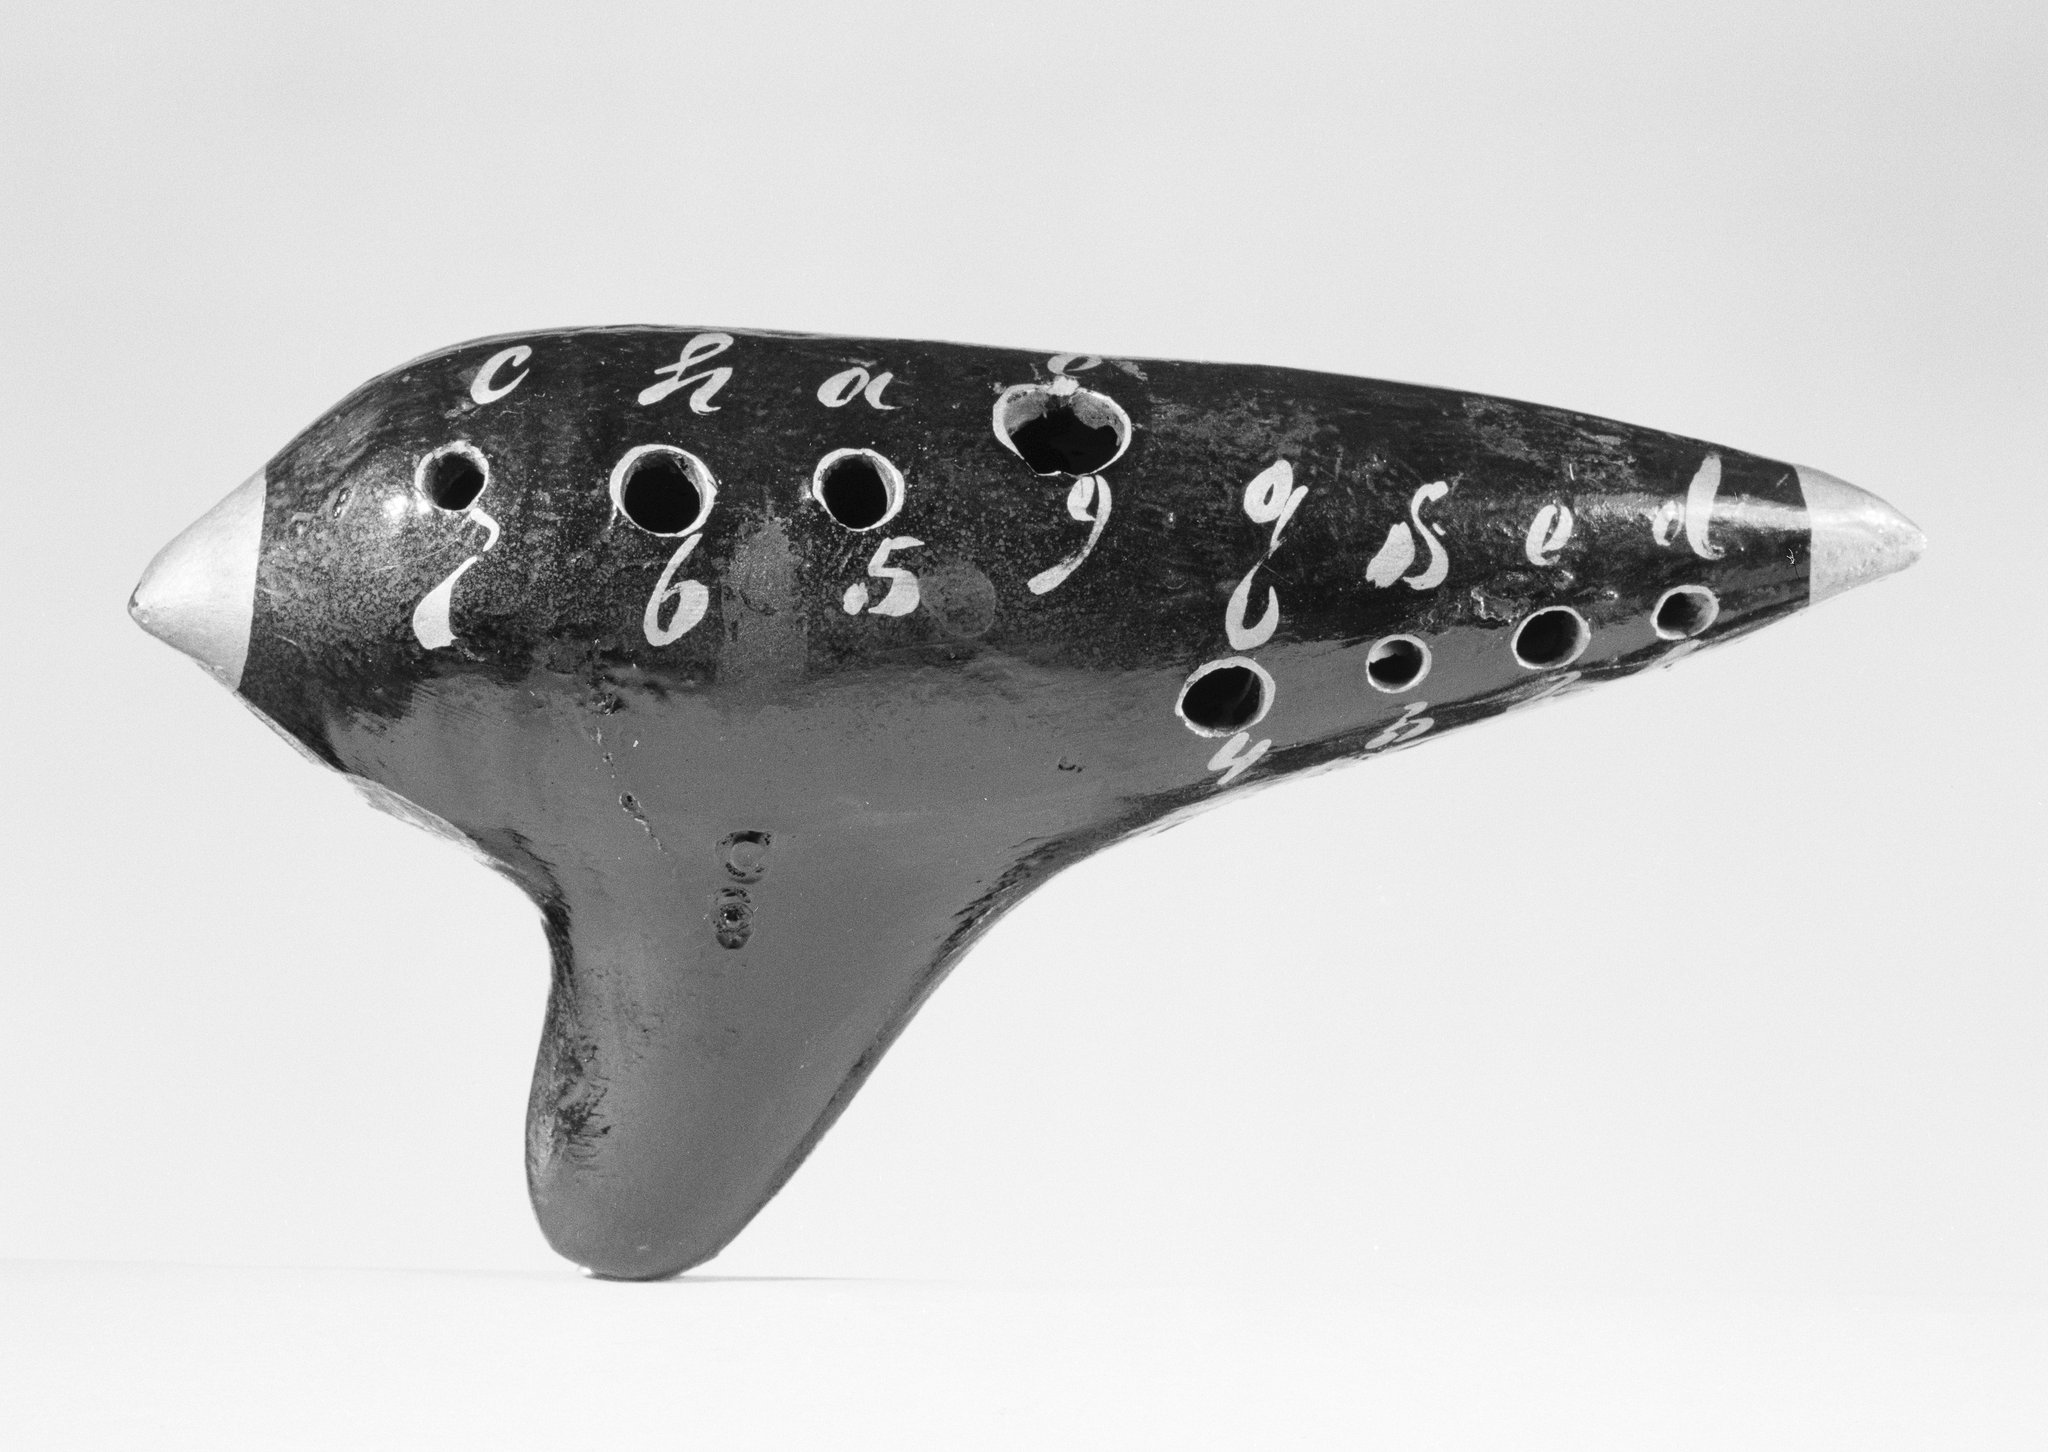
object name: ocarina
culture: austrian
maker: heinrich fiehn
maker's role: maker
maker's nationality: austrian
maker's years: 1876-1920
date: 1900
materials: clay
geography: austria